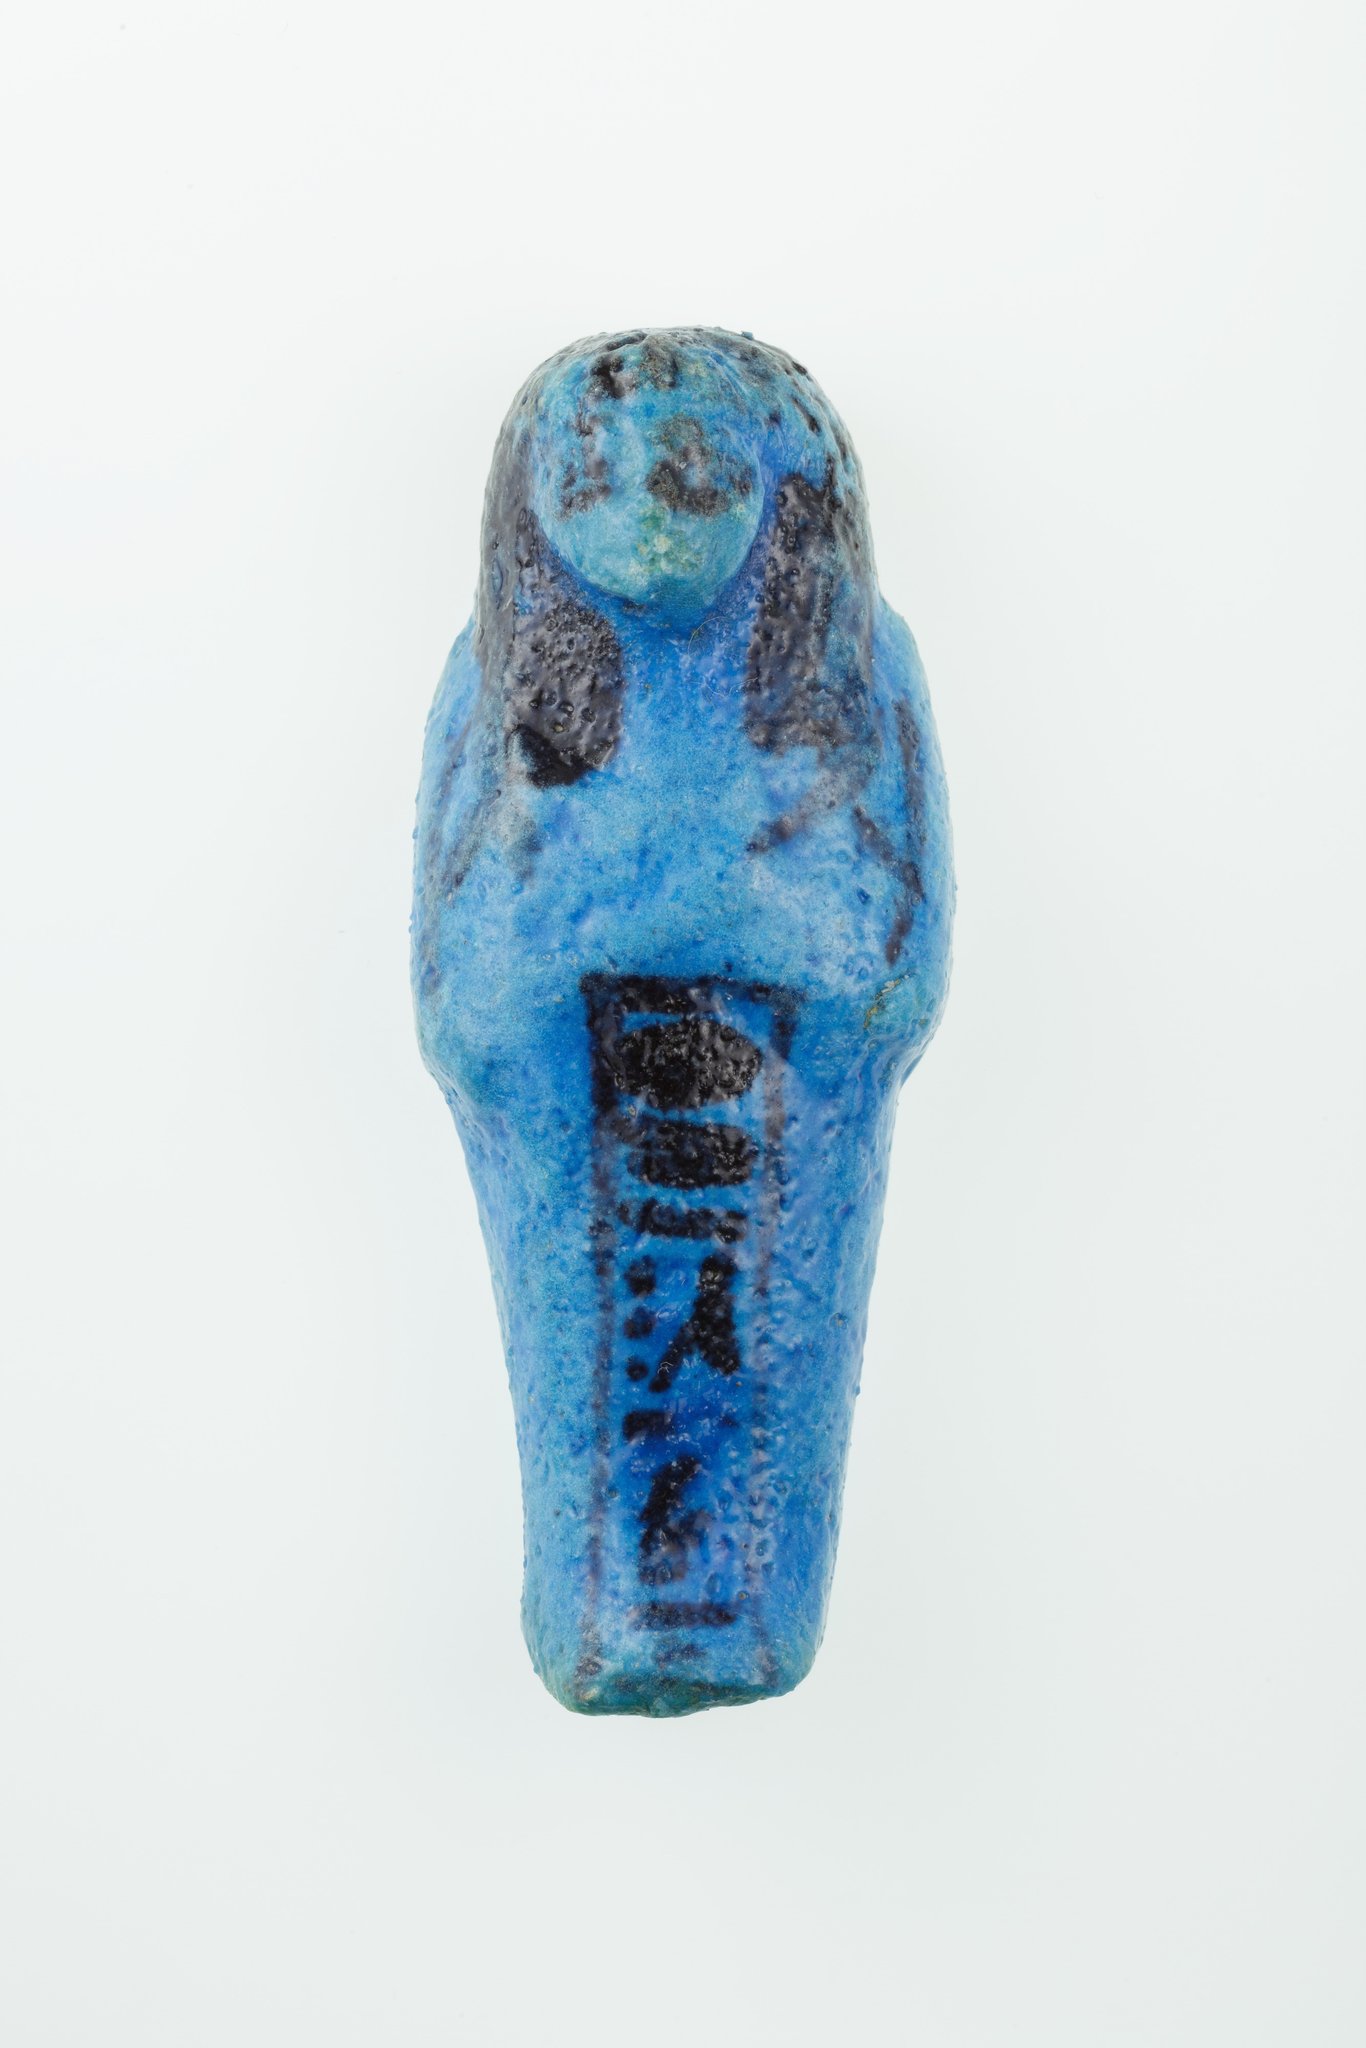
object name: shabti, worker, nauny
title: Worker Shabti of Nauny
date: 1050 BCE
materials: faience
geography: egypt